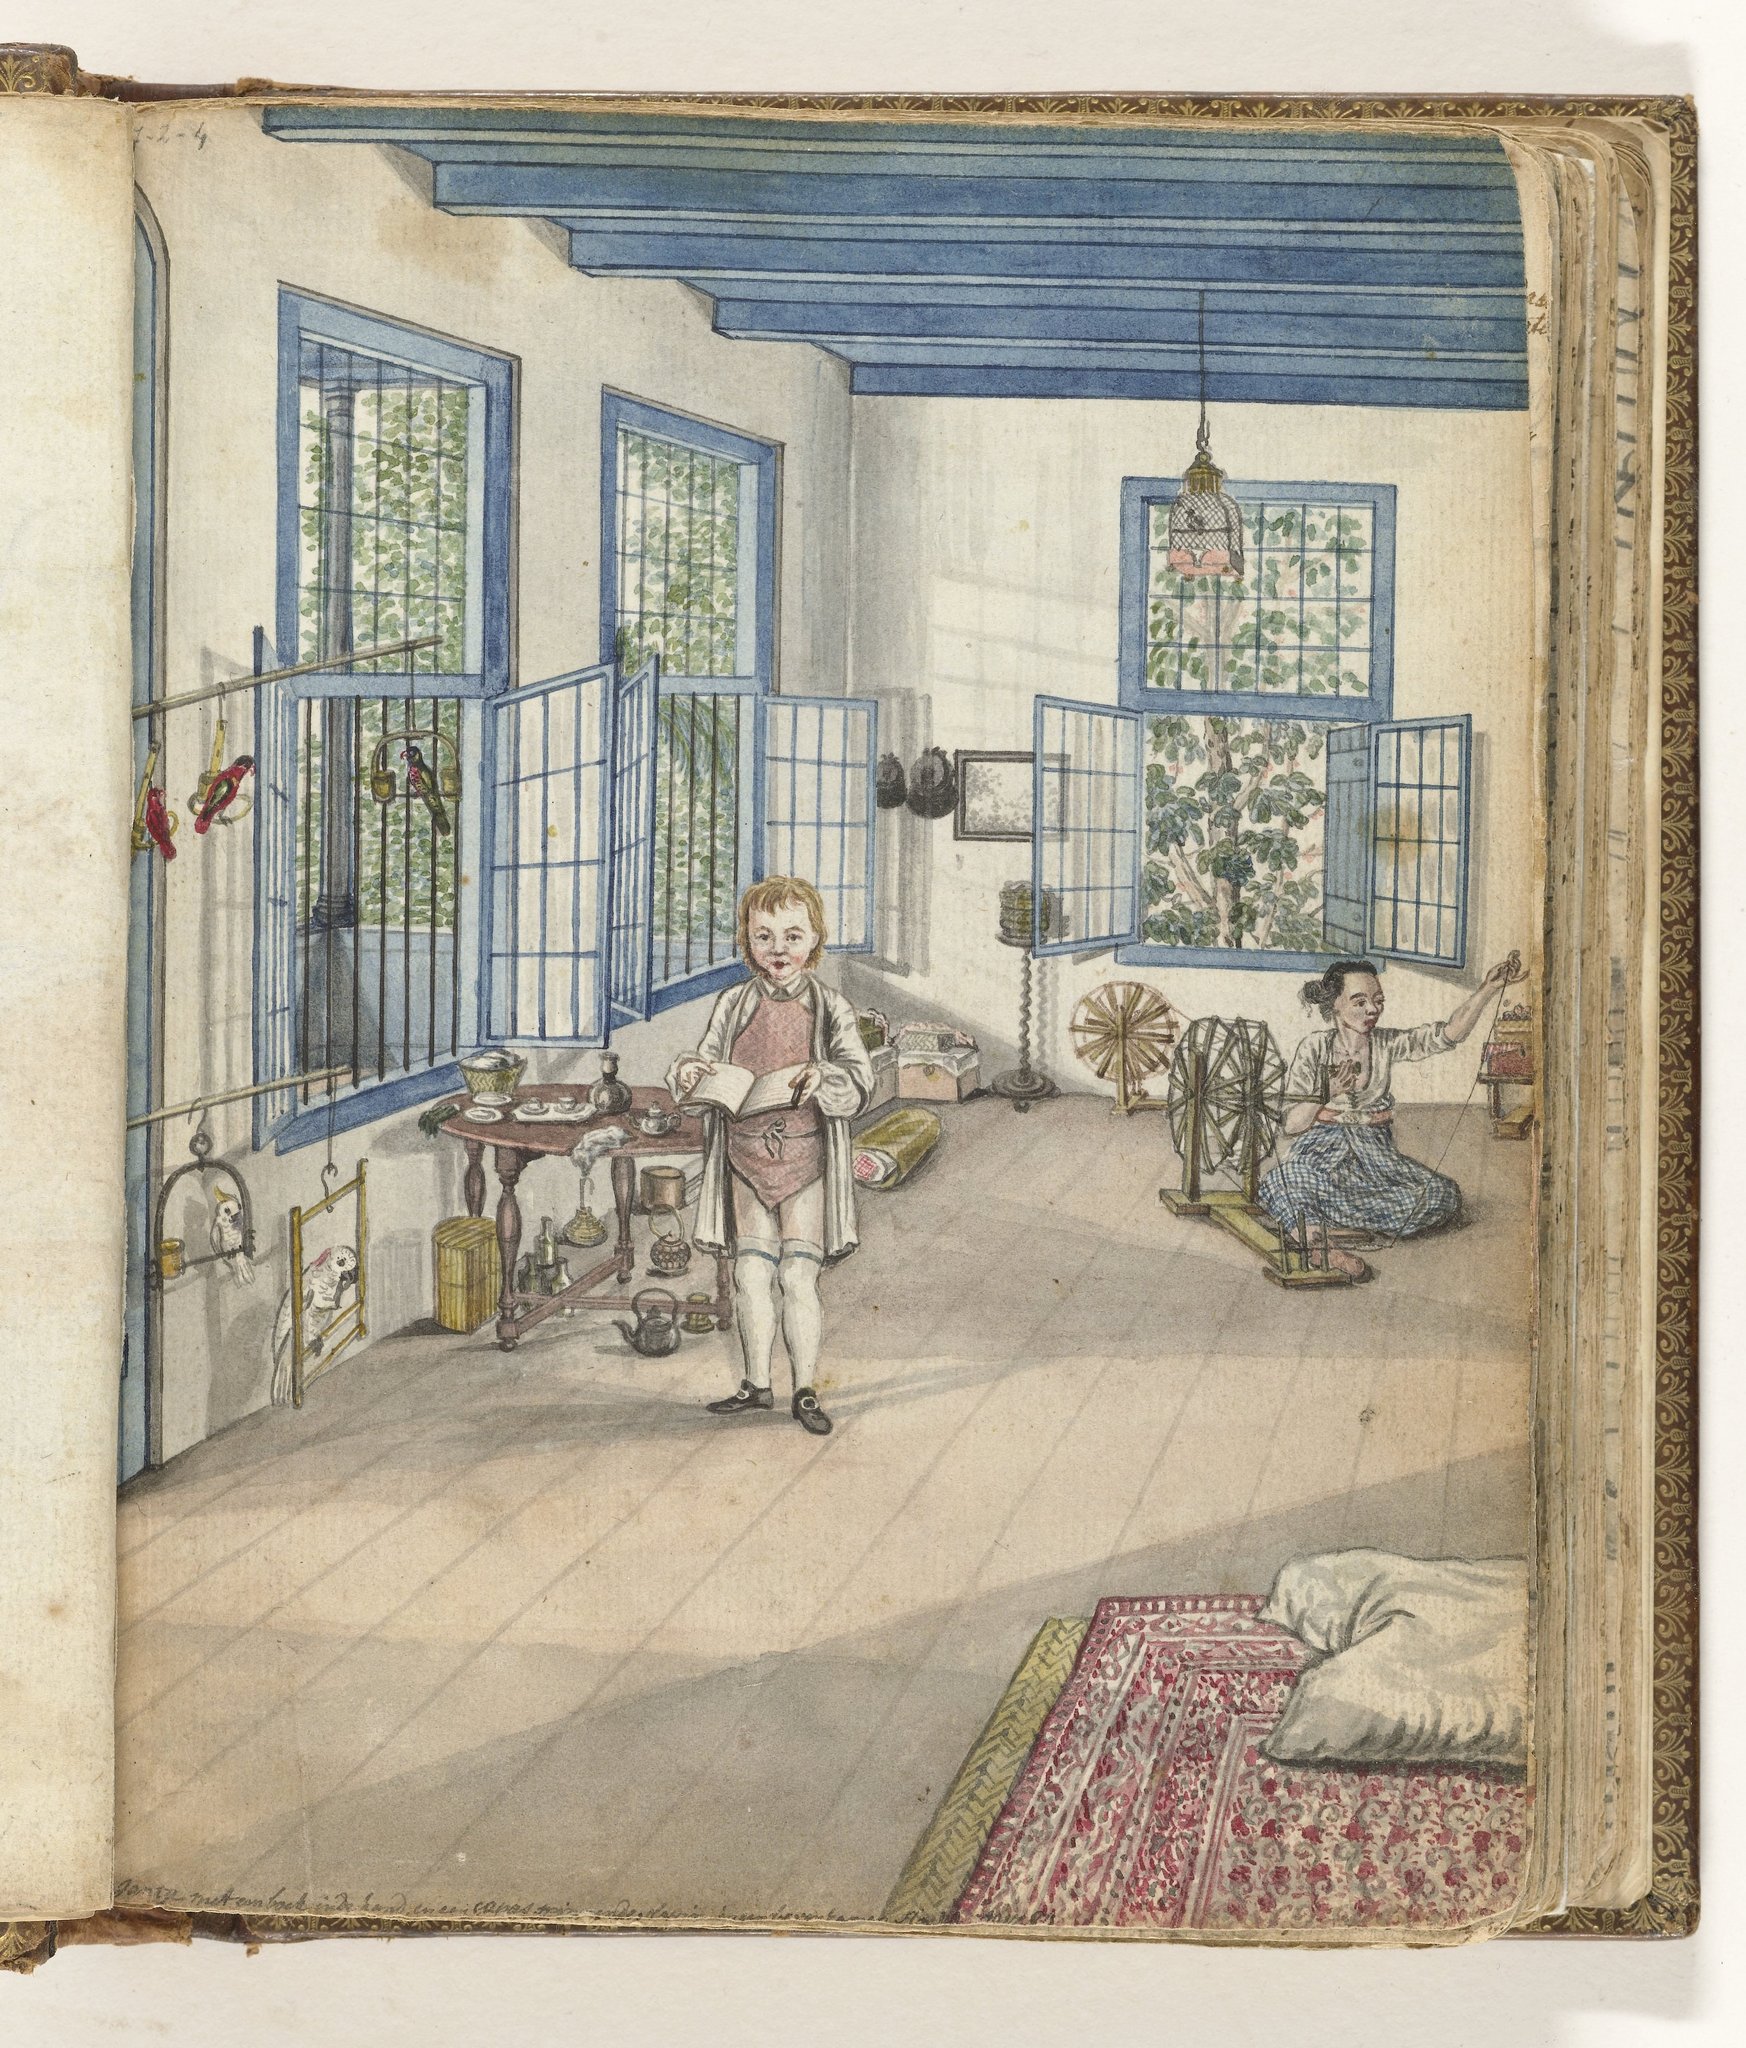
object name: drawing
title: Woonkamer met zoon Jantje en spinnende slavin Flora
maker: jan brandes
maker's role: draughtsman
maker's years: 1743-1808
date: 1784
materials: paper, pencil, watercolor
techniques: brush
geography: jakarta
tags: bodegraven, draughtsman, jan brandes, batavia, spinning-wheel, book - mm - book open, slavery; serfs and enslaved persons, interior of the house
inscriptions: inscription: ‘Jantje met een boek in de hand, en een capas spinnende slavin in een bovenkamer April 4 [?] Ao 1784’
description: Kleurtekening van de woonkamer van het huis van de tekenaar Jan Brandes met Jantje met een boek en Flora, een tot slaaf gemaakte vrouw, in kleermakerszit bij een spinnewiel. Verder een tapijt, meubels, huisdieren. Met opschrift. Onderdeel uit het schetsboek van Jan Brandes, dl. 2 (1808), p. 7.